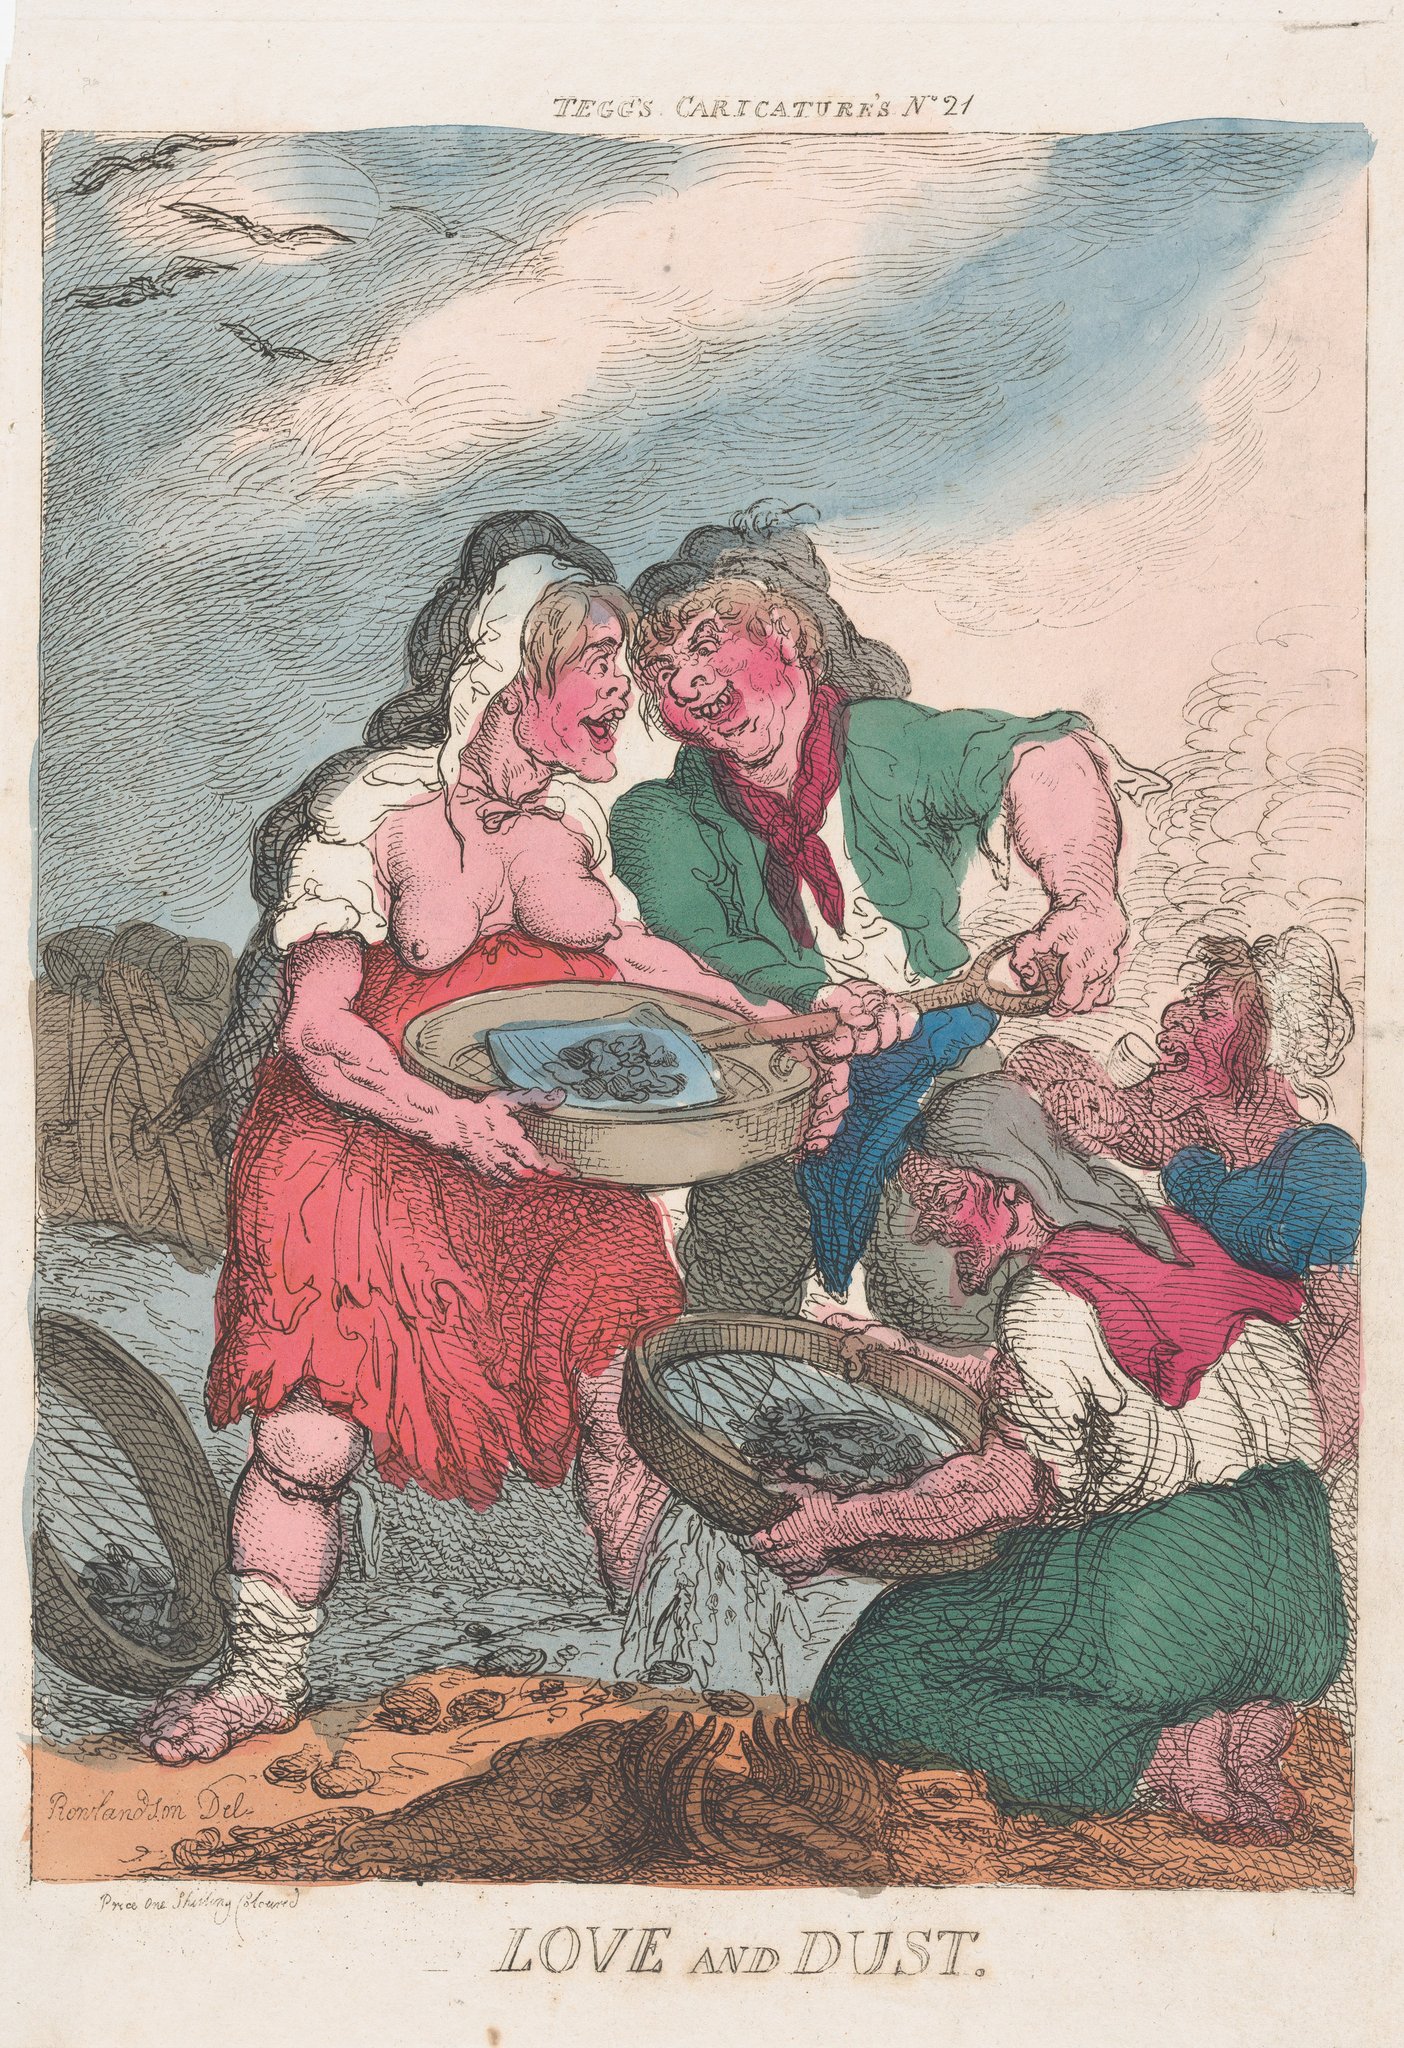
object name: print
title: Love and Dust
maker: thomas rowlandson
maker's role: artist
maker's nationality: british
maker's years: 1757-1827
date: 1810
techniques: etching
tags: satire,men,female nudes